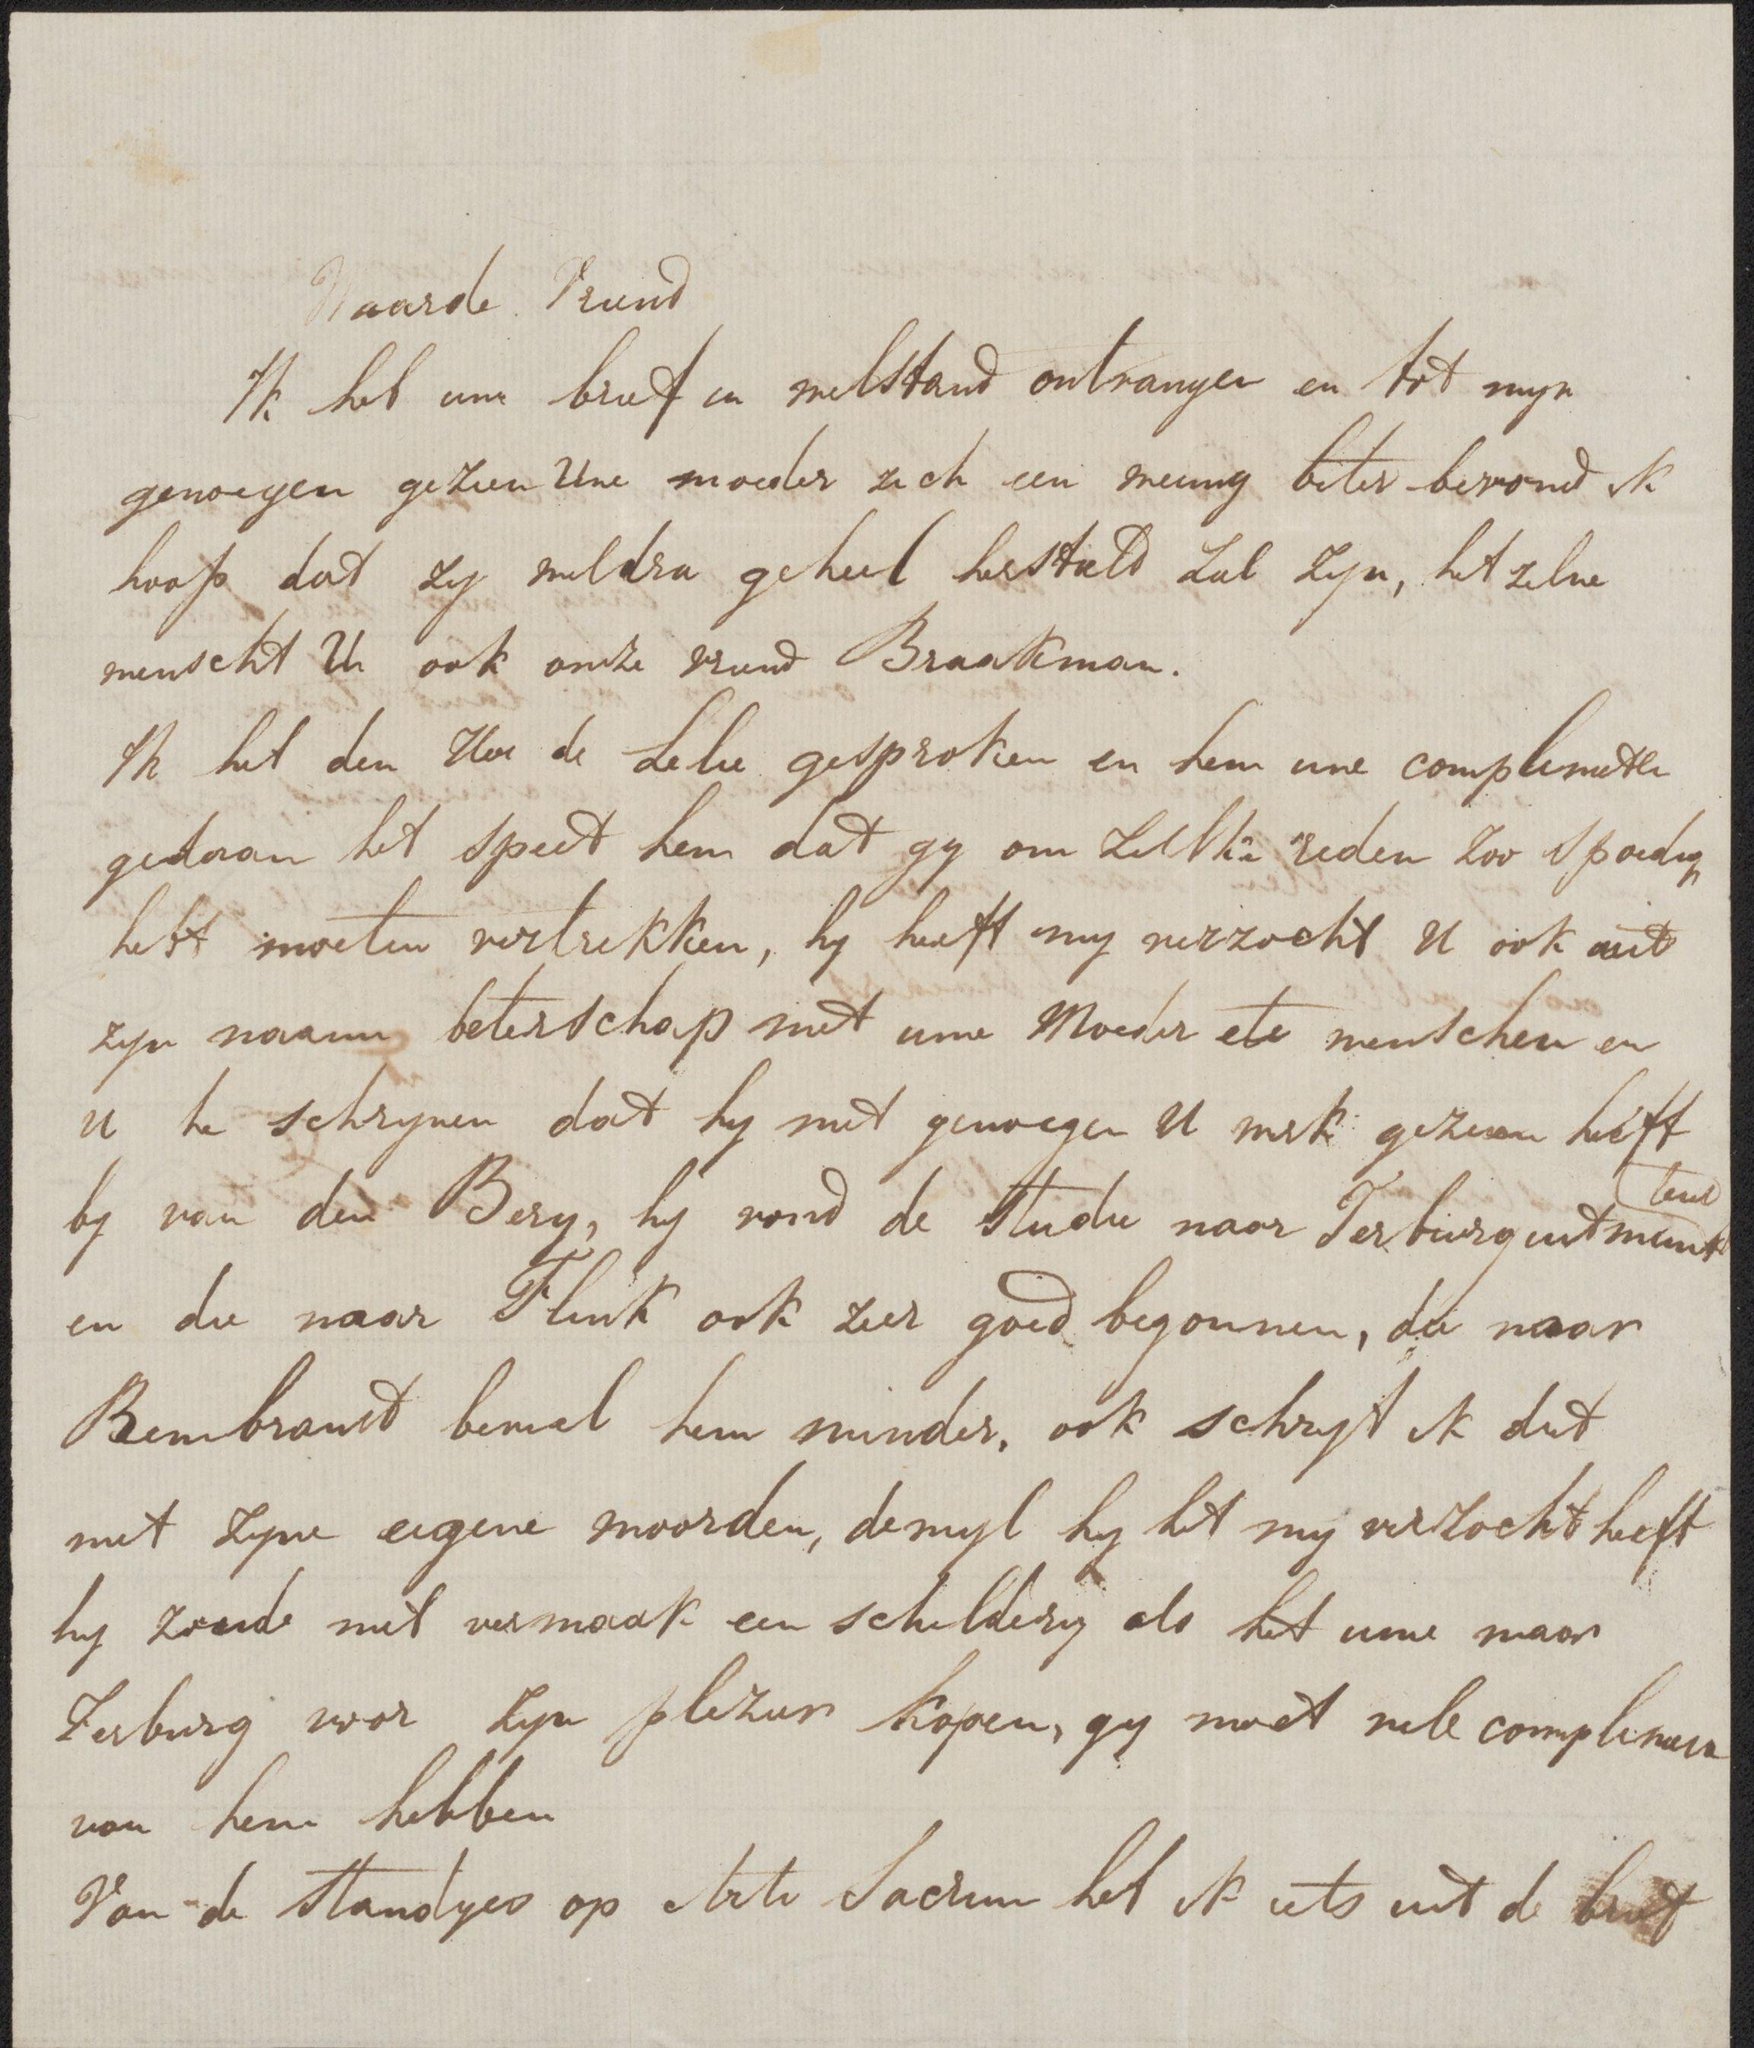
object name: letter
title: Brief aan Ary Johannes Lamme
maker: robert van eijsden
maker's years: 1810-1890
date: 1832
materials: ink, paper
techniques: pen, writing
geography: amsterdam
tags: dordrecht, print maker, ary johannes lamme, amsterdam, jan adriaan antonie de lelie, rotterdam, painter, draughtsman, anton braakman, family life, painting (including book-illumination, miniature-painting), diseases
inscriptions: watermark, collector's mark: Lugt 2228